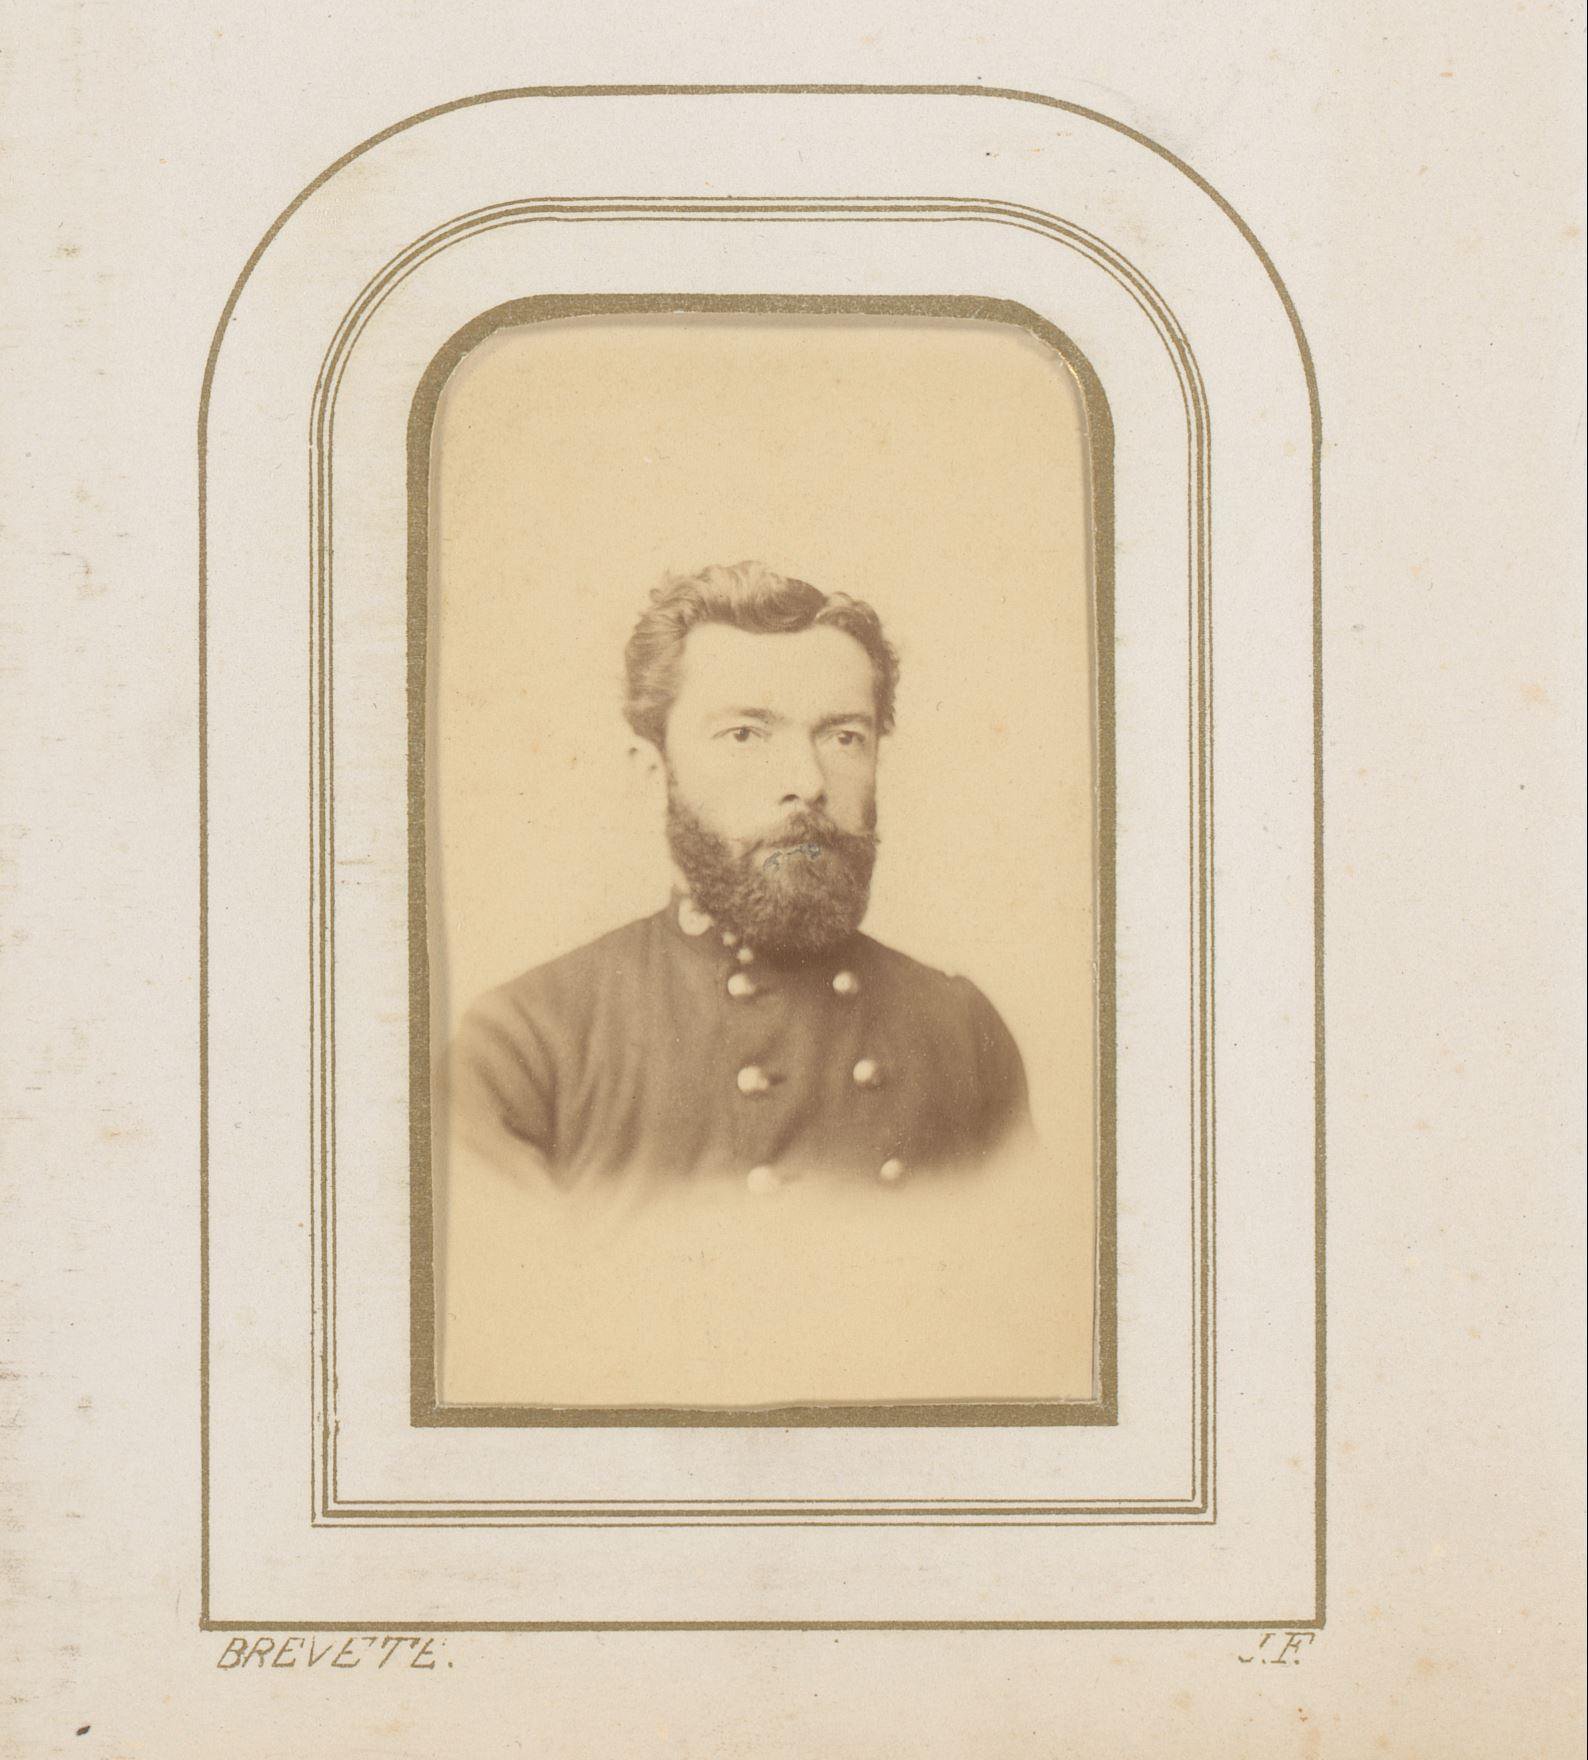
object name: carte de visite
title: Portret van een man met baard in uniform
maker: charles de trez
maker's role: painter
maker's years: 1822-1899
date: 1860-1882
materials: cardboard, photographic support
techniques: albumen print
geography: brussels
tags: historical persons, (military) uniforms, beard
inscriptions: number: ‘2’, inscription: ‘C. De Trez/ Photographe/ rue du Pont Neuf/ No 1/ Bruxelles’